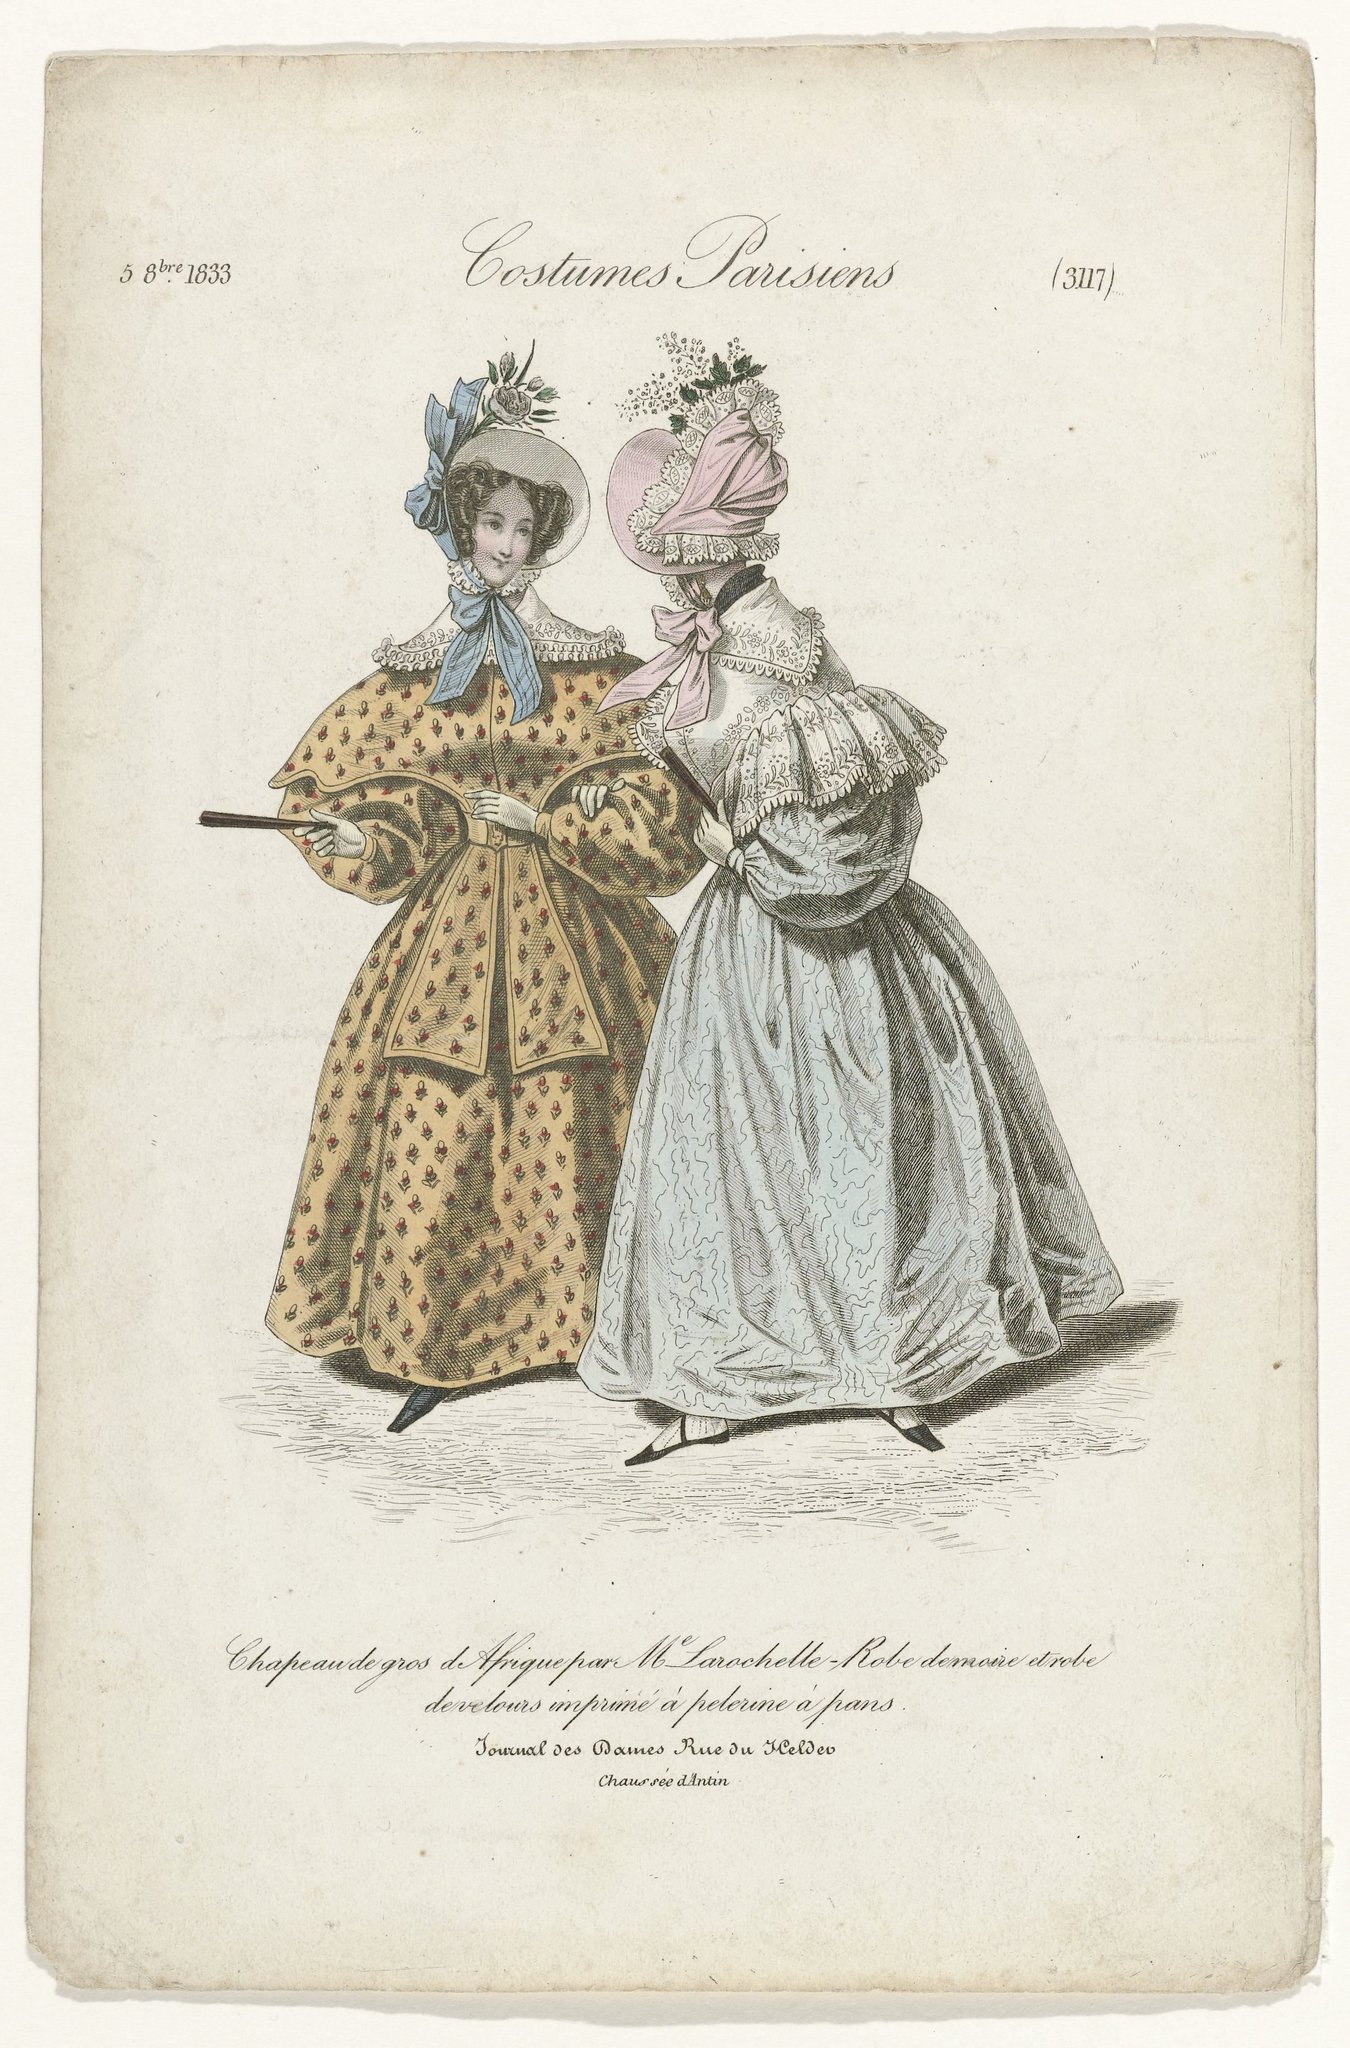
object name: fashion print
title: Journal des Dames et des Modes, Costumes Parisiens, 5 octobre 1833, (3117): Chapeau de gros de Afriqu (...)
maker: Anonymous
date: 1833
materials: paper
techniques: engraving, hand coloring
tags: arm in arm (friends), clothing for the upper part of the body (mantelet) (+ women's clothes), fashion plates, head-gear: hat (+ women's clothes), dress, gown (+ women's clothes)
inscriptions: caption: ‘Chapeau de gros de Afrique par Me Larochelle - Robe de moire et robe de velours imprimé à pelerine à pans.’, title: ‘Costumes Parisiens.’, address: ‘Journal des Dames Rue du Helder Chaussée d'Antin’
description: Twee vrouwen wandelen arm in arm. Hoed van ´gros de Afrique´ van Me Larochelle. Japon van moiré (zijde) en een japon van bedrukt fluweel met 'pelerine à pans´. De prent maakt deel uit van het modetijdschrift Journal des Dames et des Modes, Parijs, 1797-1839.